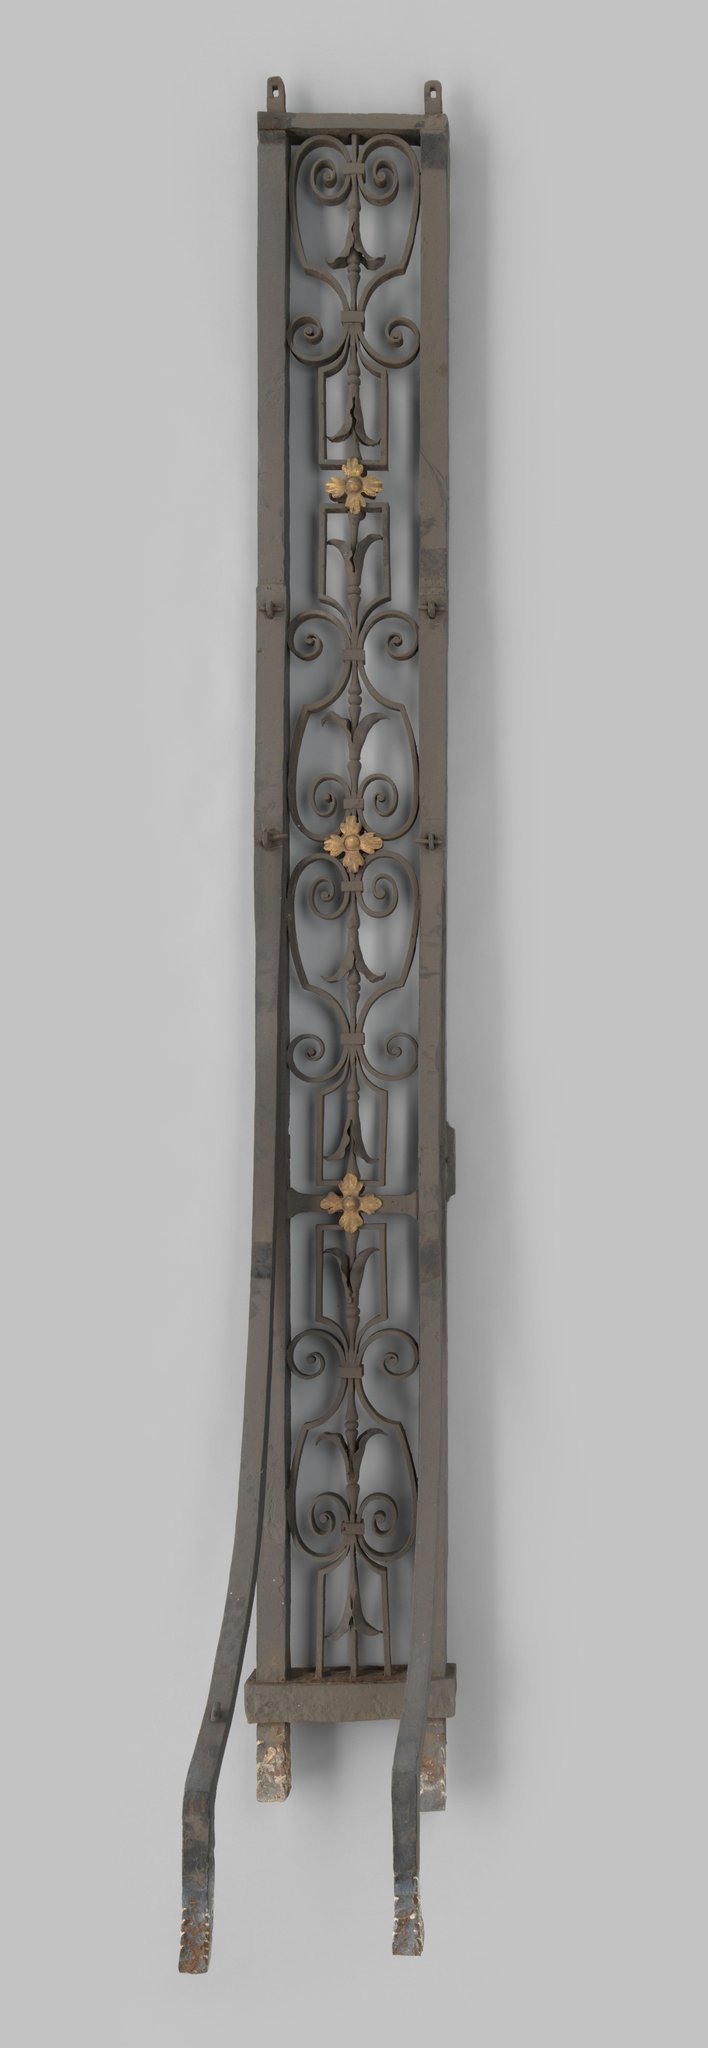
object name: hek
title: Sierhekdeel van het inrijhek Huize de Voorst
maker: daniël marot (i)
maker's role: draughtsman, print maker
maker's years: 1661-1752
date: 1675-1700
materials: iron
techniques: forging, gilding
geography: warnsveld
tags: huis de voorst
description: Smeedijzeren sierhekdeel van het inrijhek van Huize de Voorst.